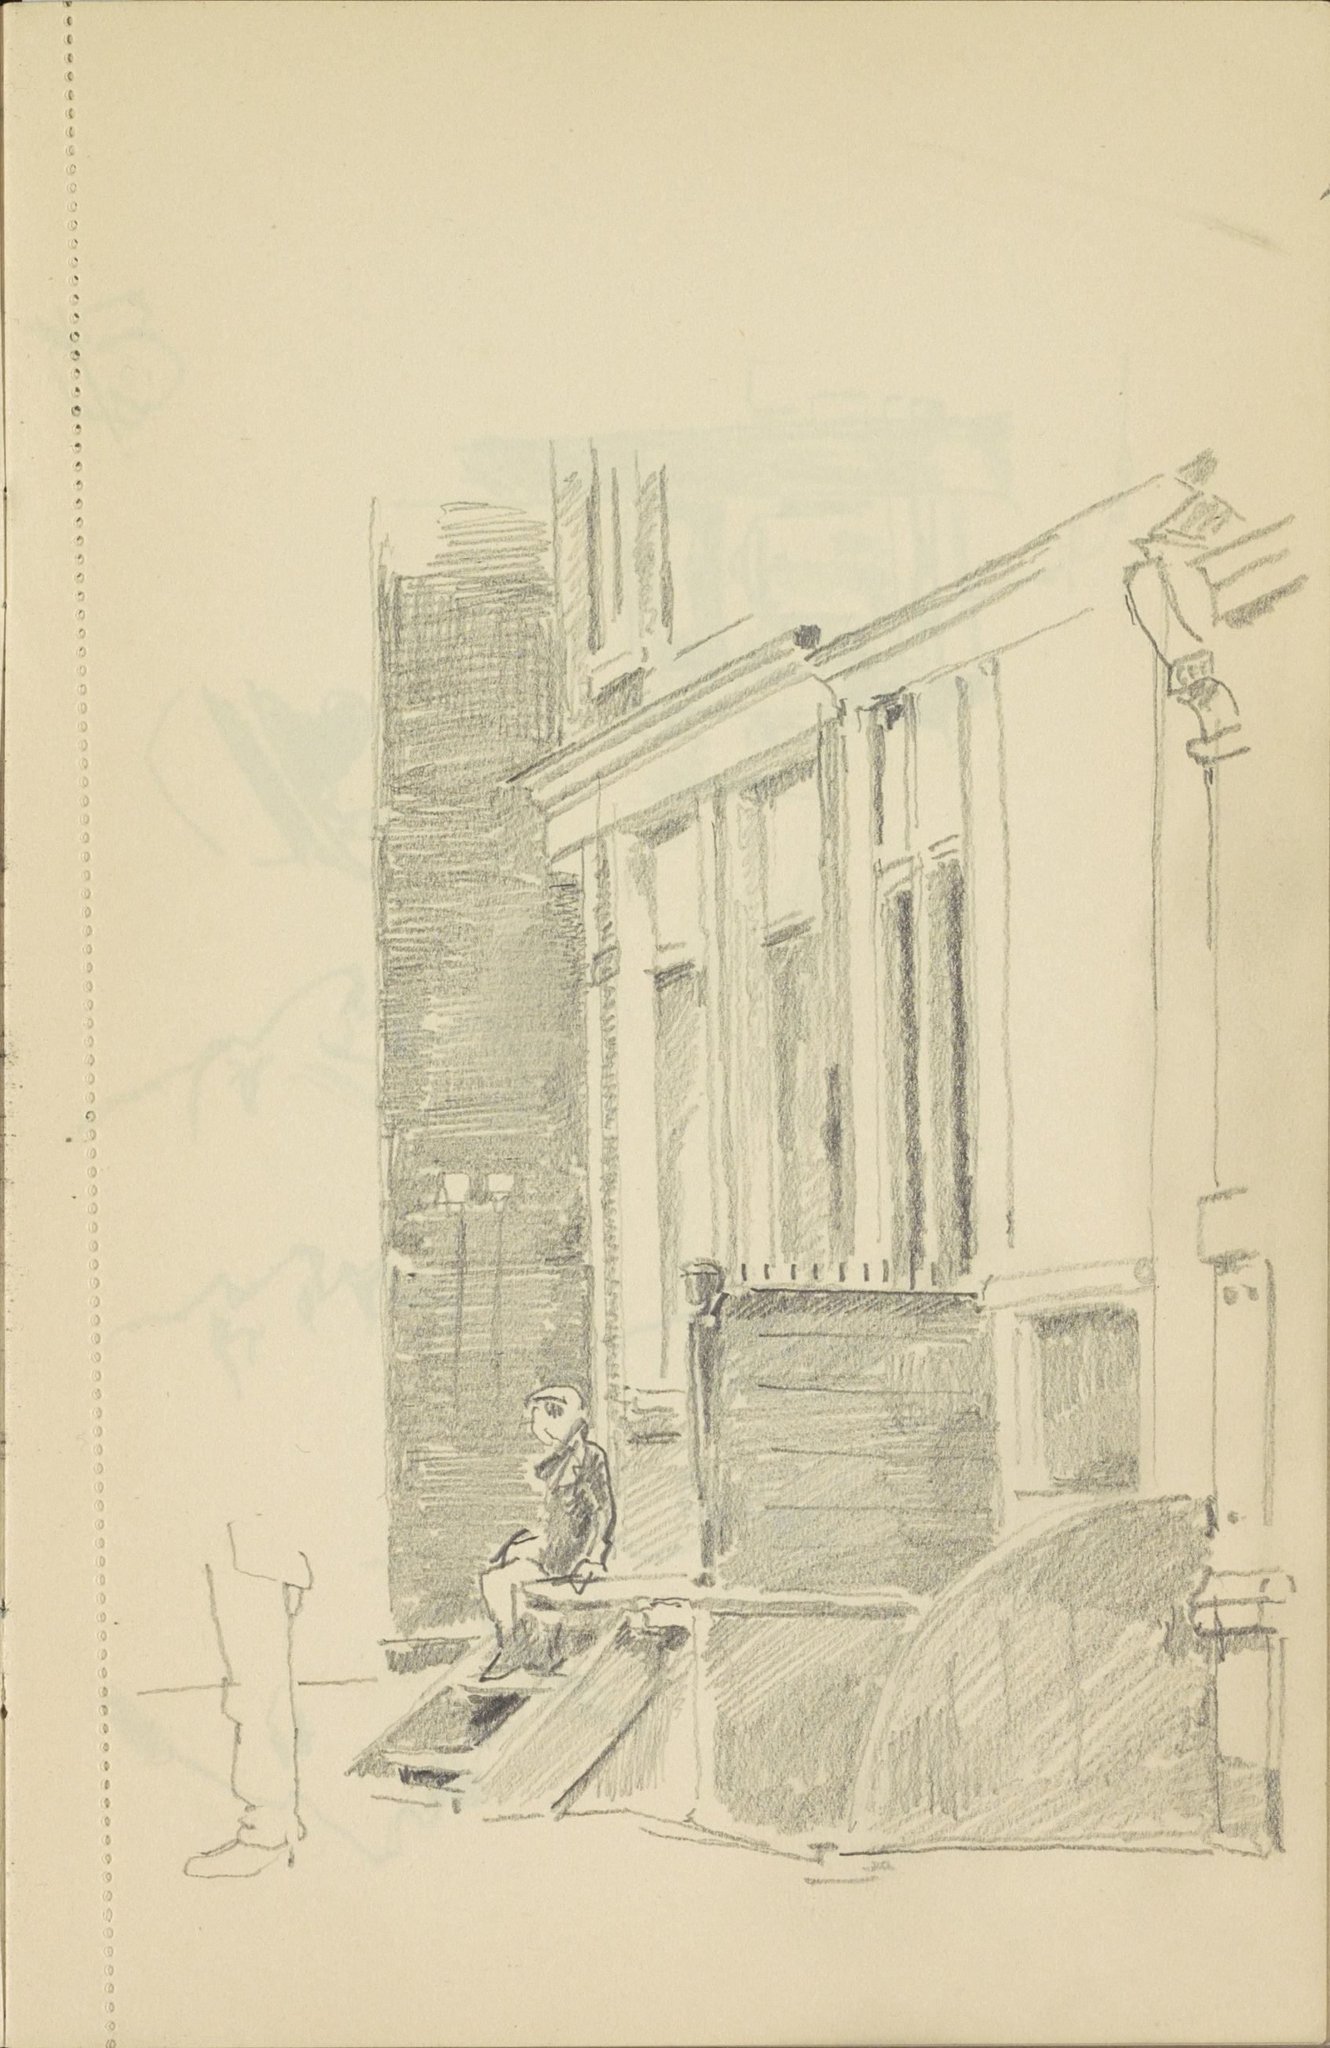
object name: sketchbook leaf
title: Zittende figuur op een trap voor een huis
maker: cornelis vreedenburgh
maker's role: draughtsman, print maker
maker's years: 1880-1946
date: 1890-1946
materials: paper, pencil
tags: sitting figure, flight of steps, façade (of house or building)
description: Tevens een studie van een been. Blad 25 recto uit een schetsboek met 73 bladen.